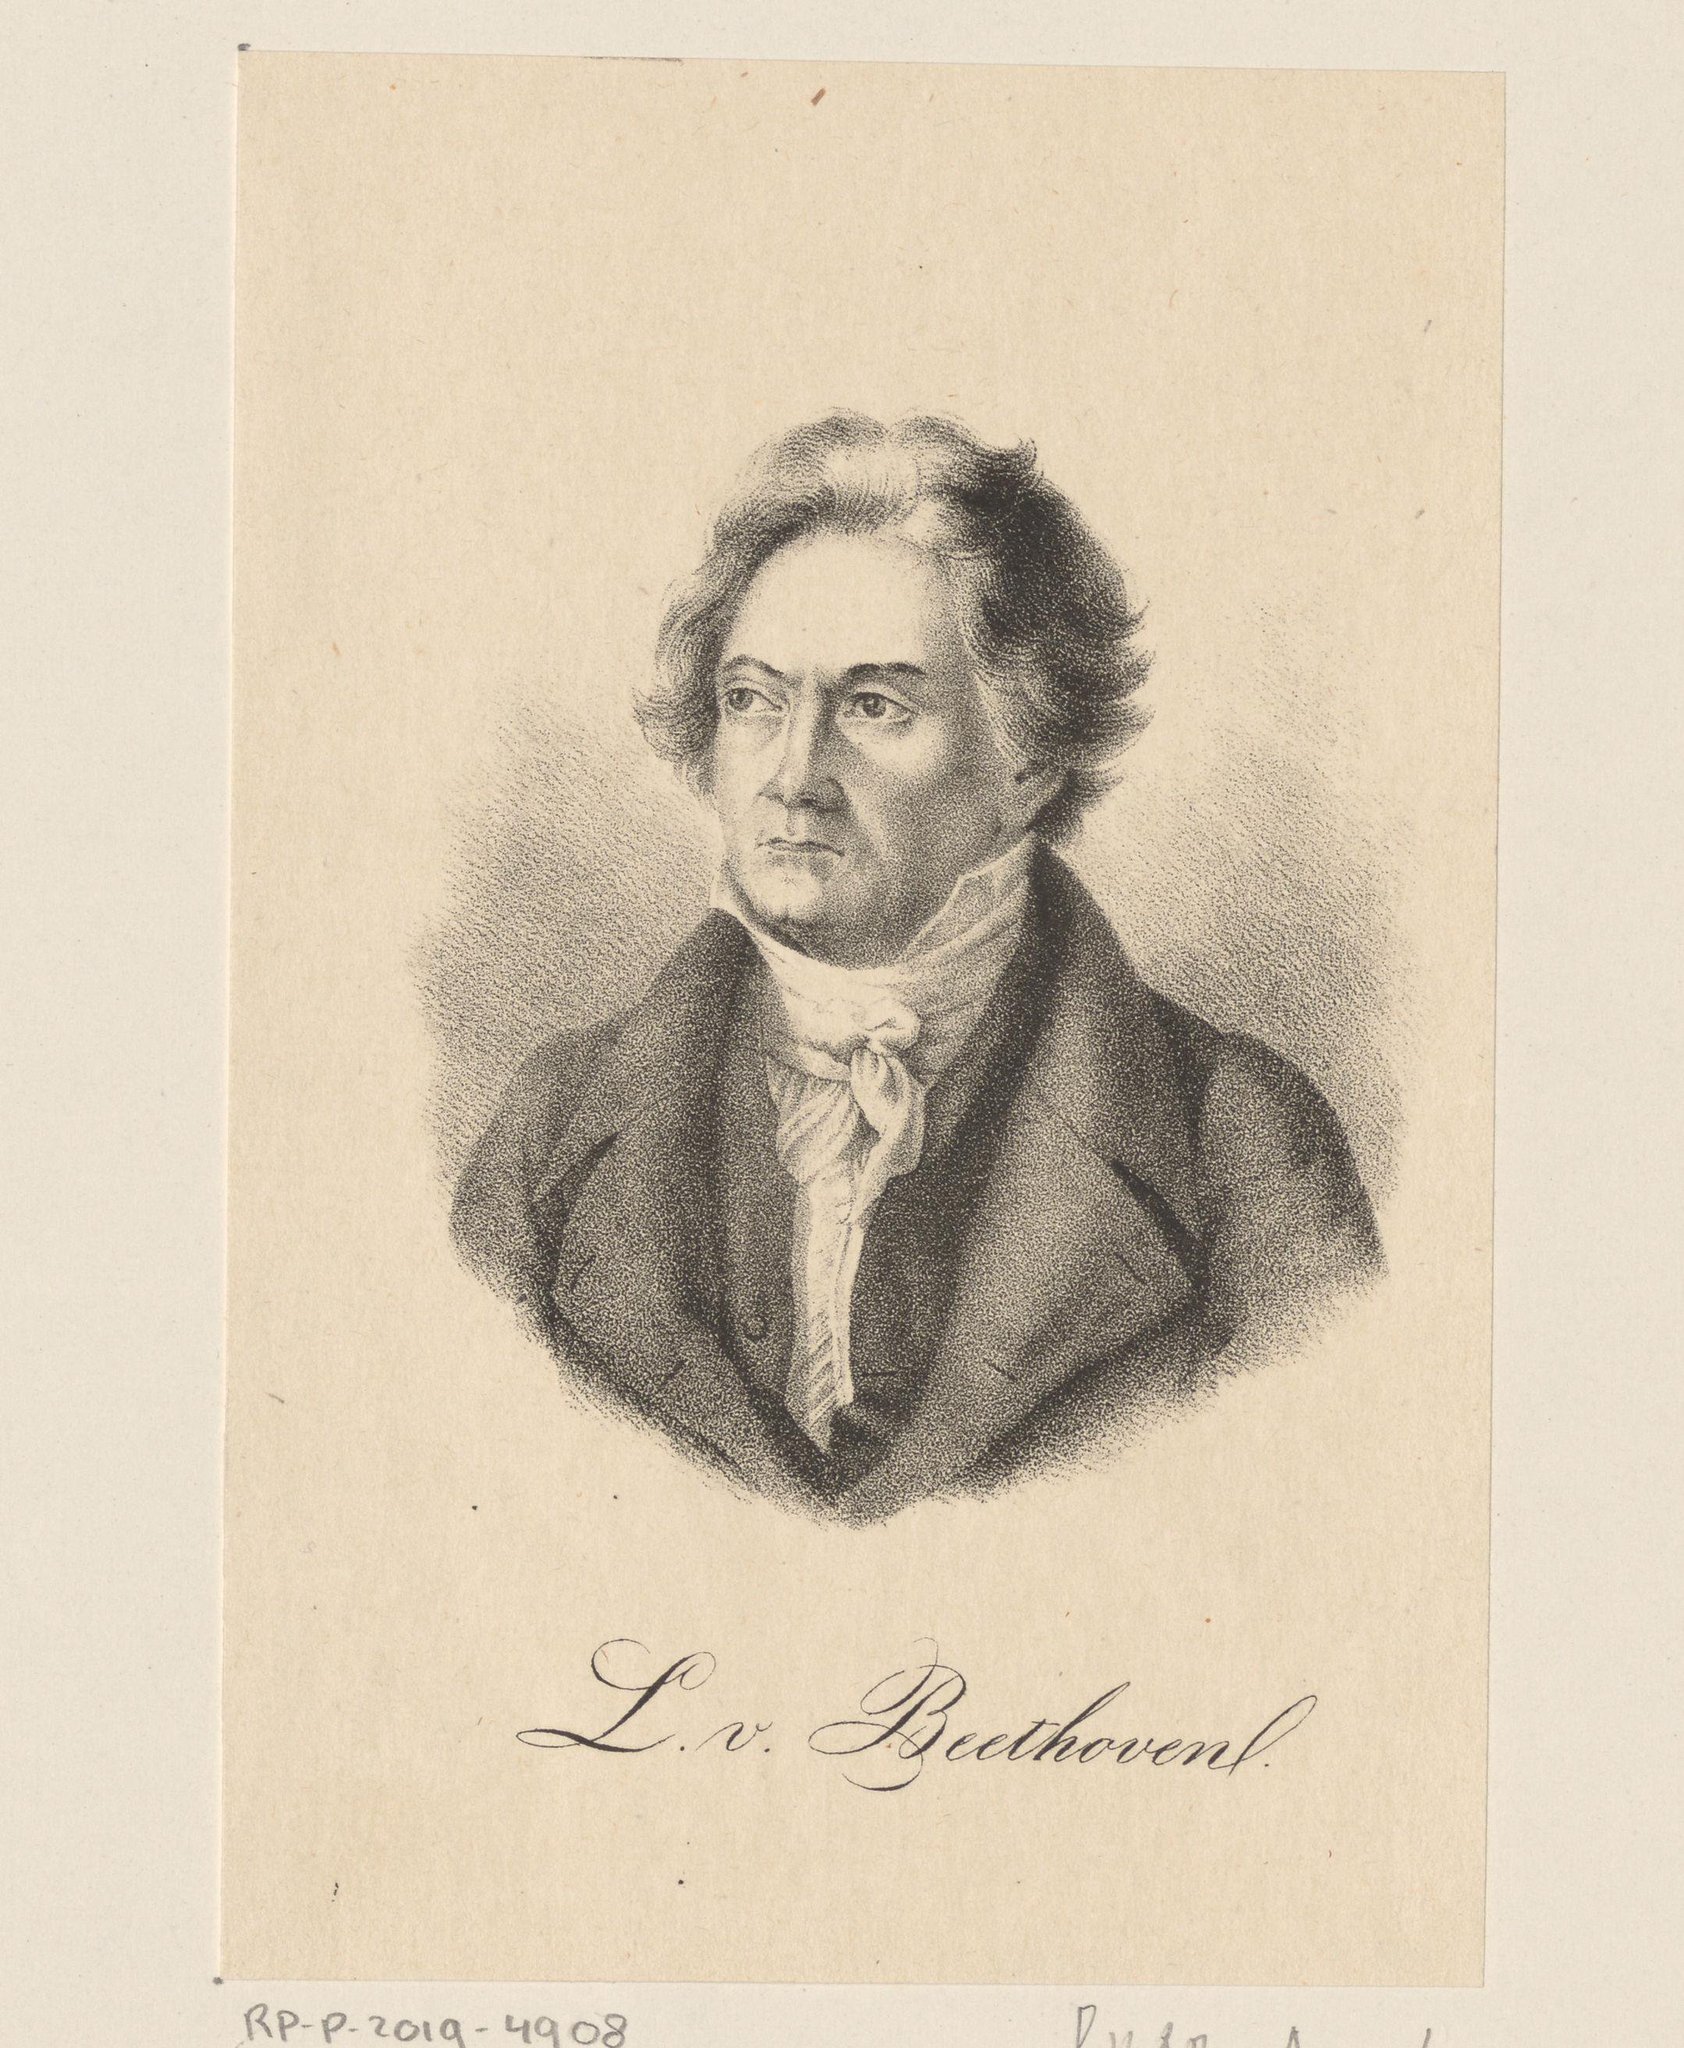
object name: print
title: Portret van Ludwig van Beethoven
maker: Anonymous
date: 1800-1899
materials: paper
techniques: lithograph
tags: vienna, historical persons, portrait of composer